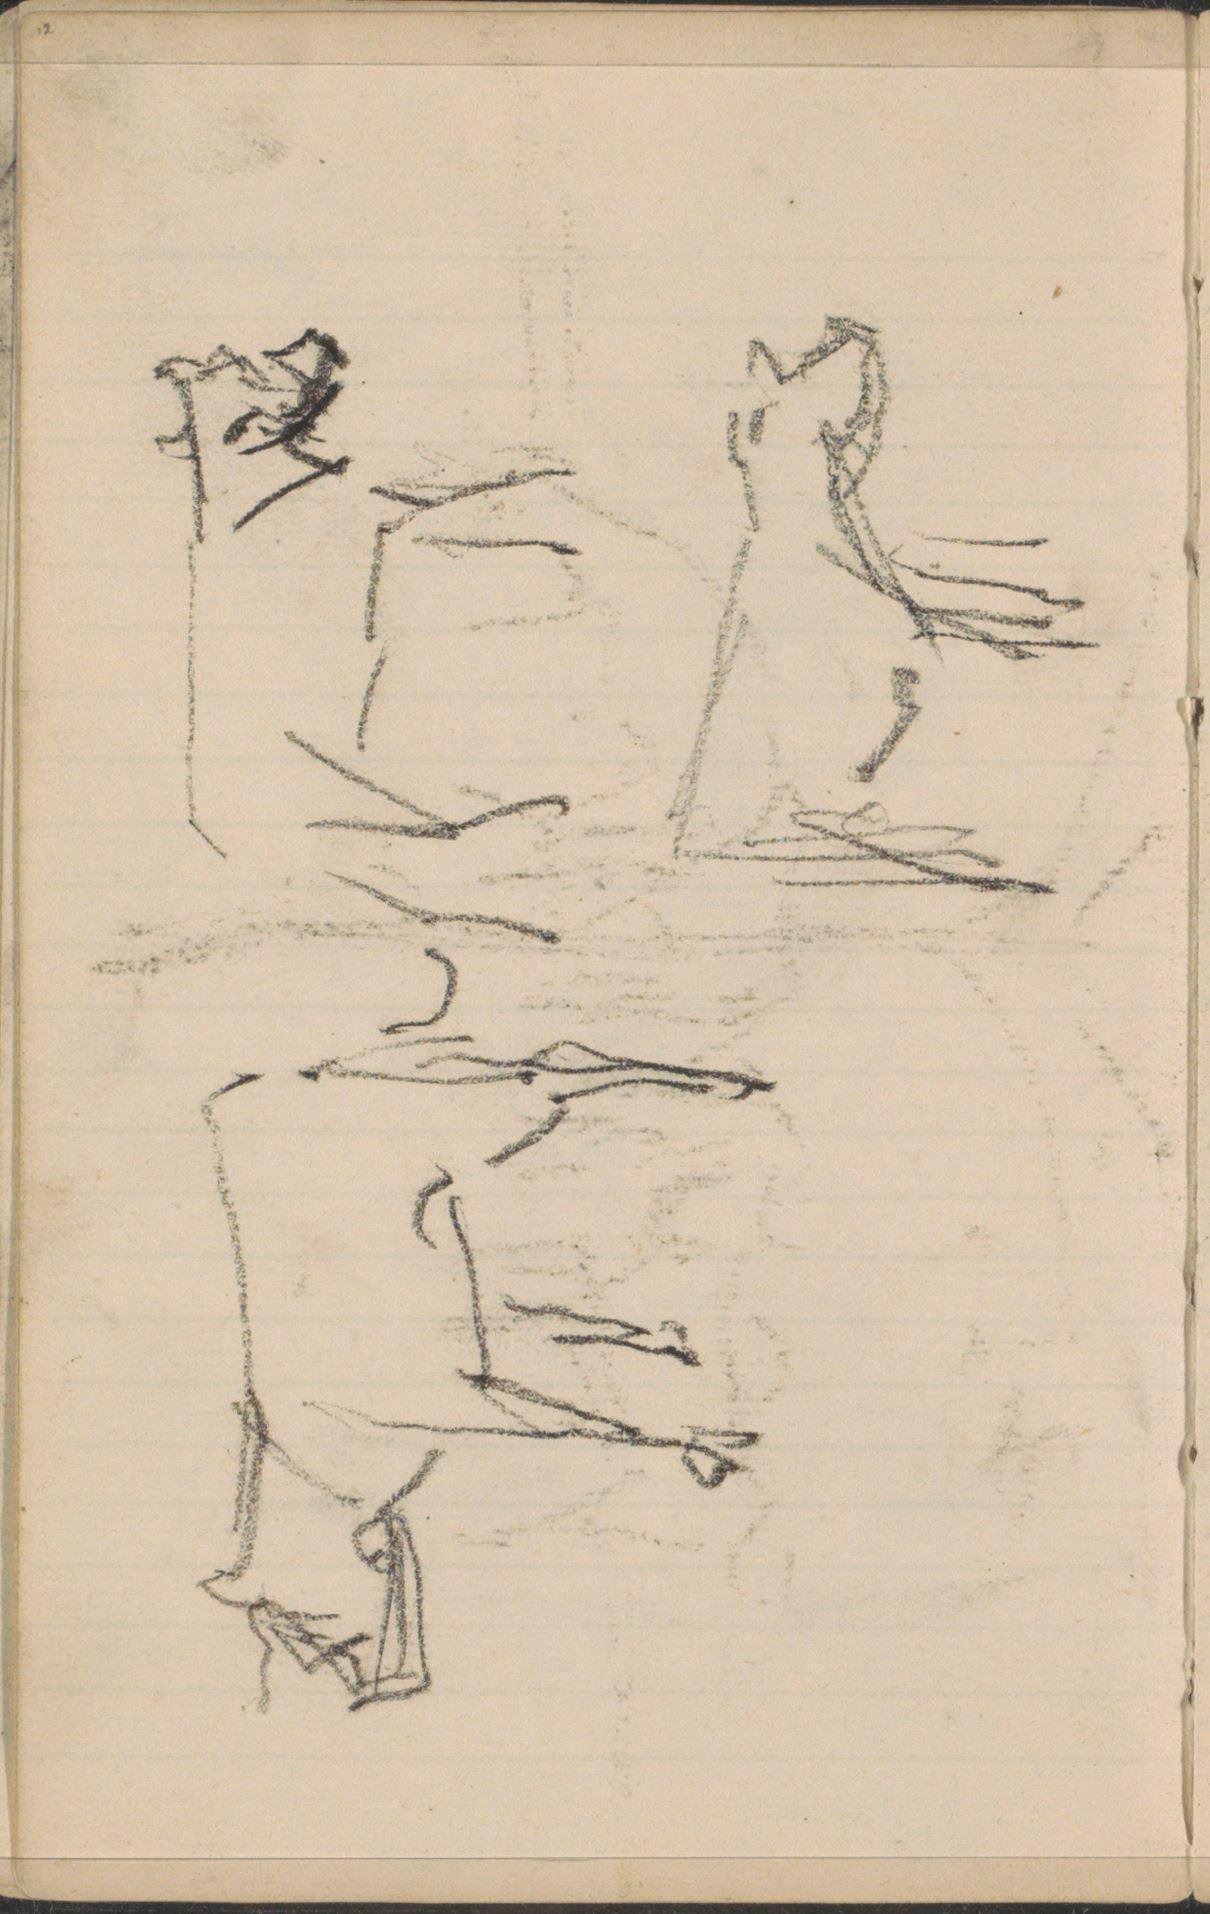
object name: sketchbook leaf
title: Koeien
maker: marius bauer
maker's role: draughtsman, print maker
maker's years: 1867-1932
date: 1881-1885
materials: chalk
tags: cow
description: Pagina 12 uit een schetsboek met 26 bladen.